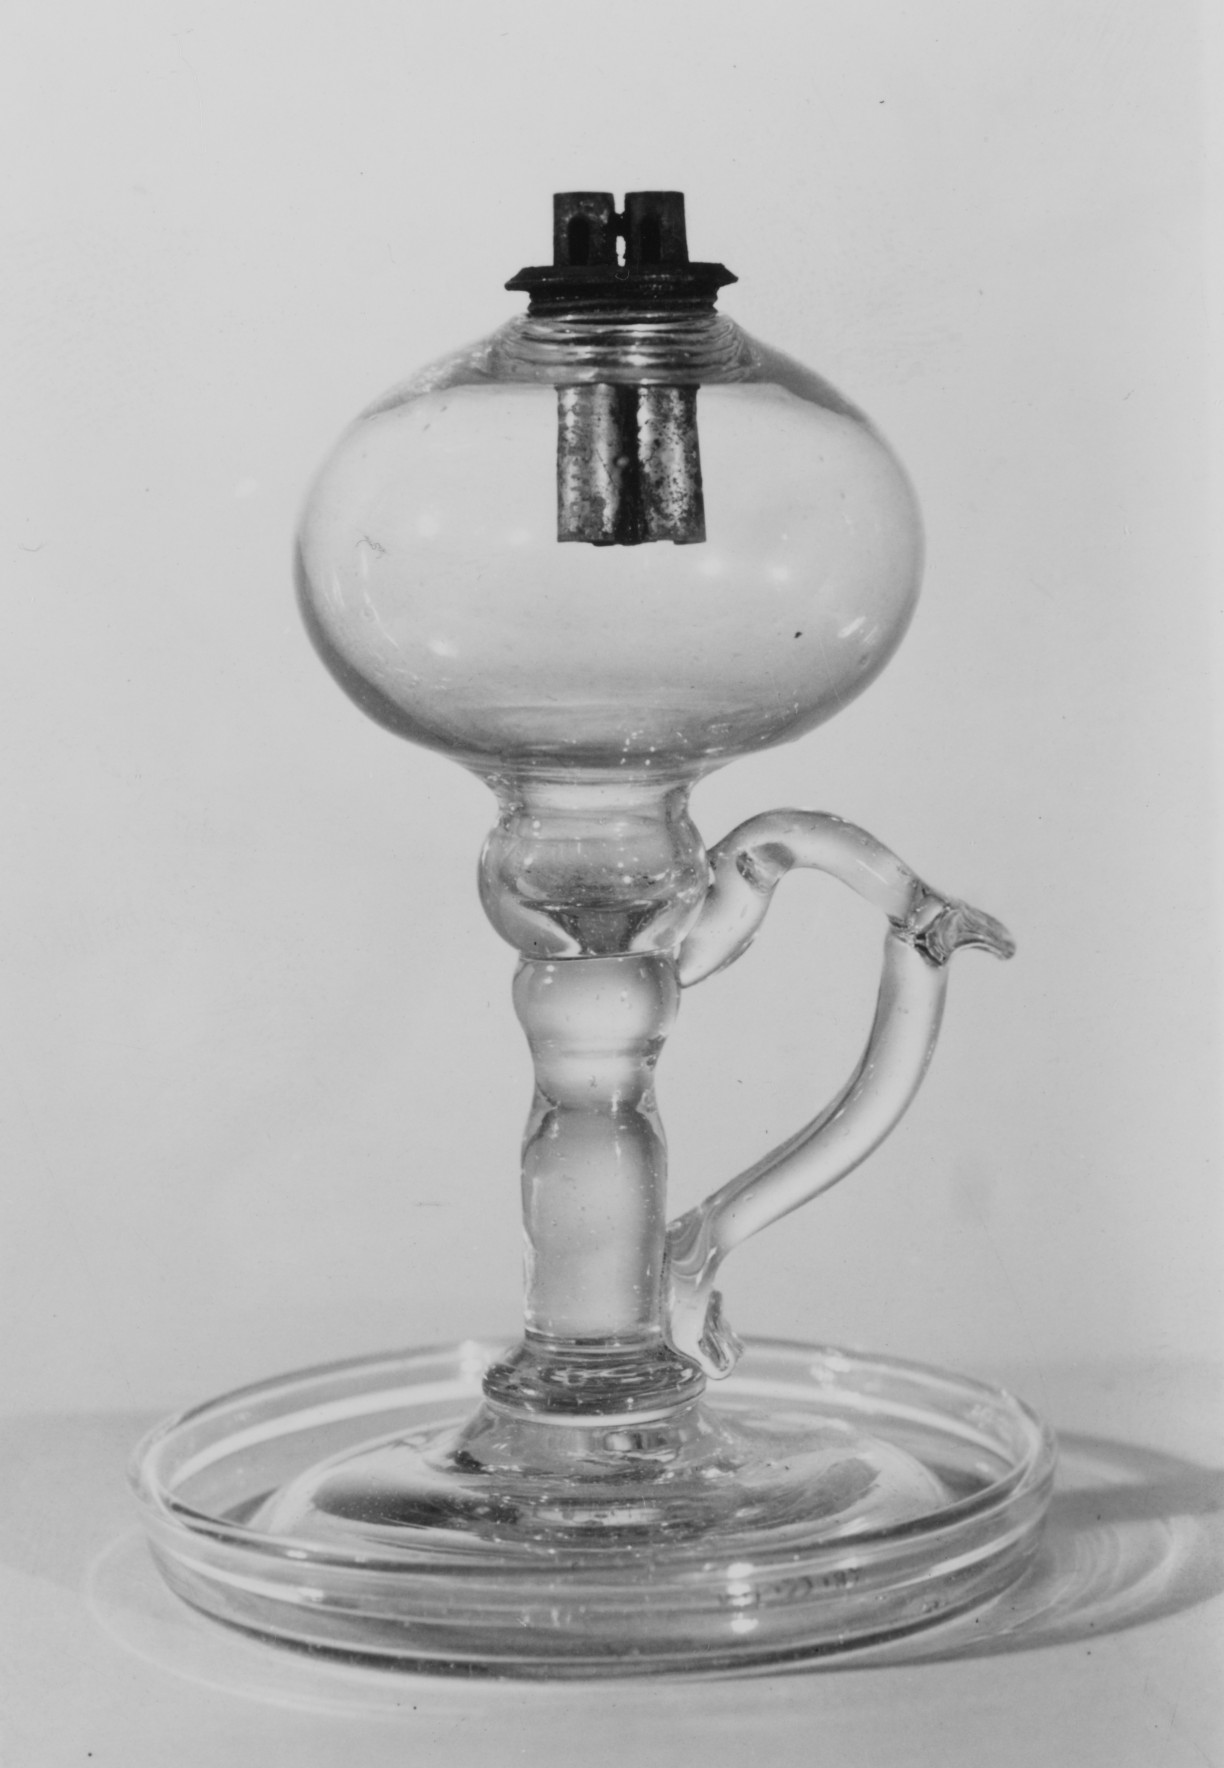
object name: lamp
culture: american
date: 1801-1900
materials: gemstone, glass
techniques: glassblowing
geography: united states